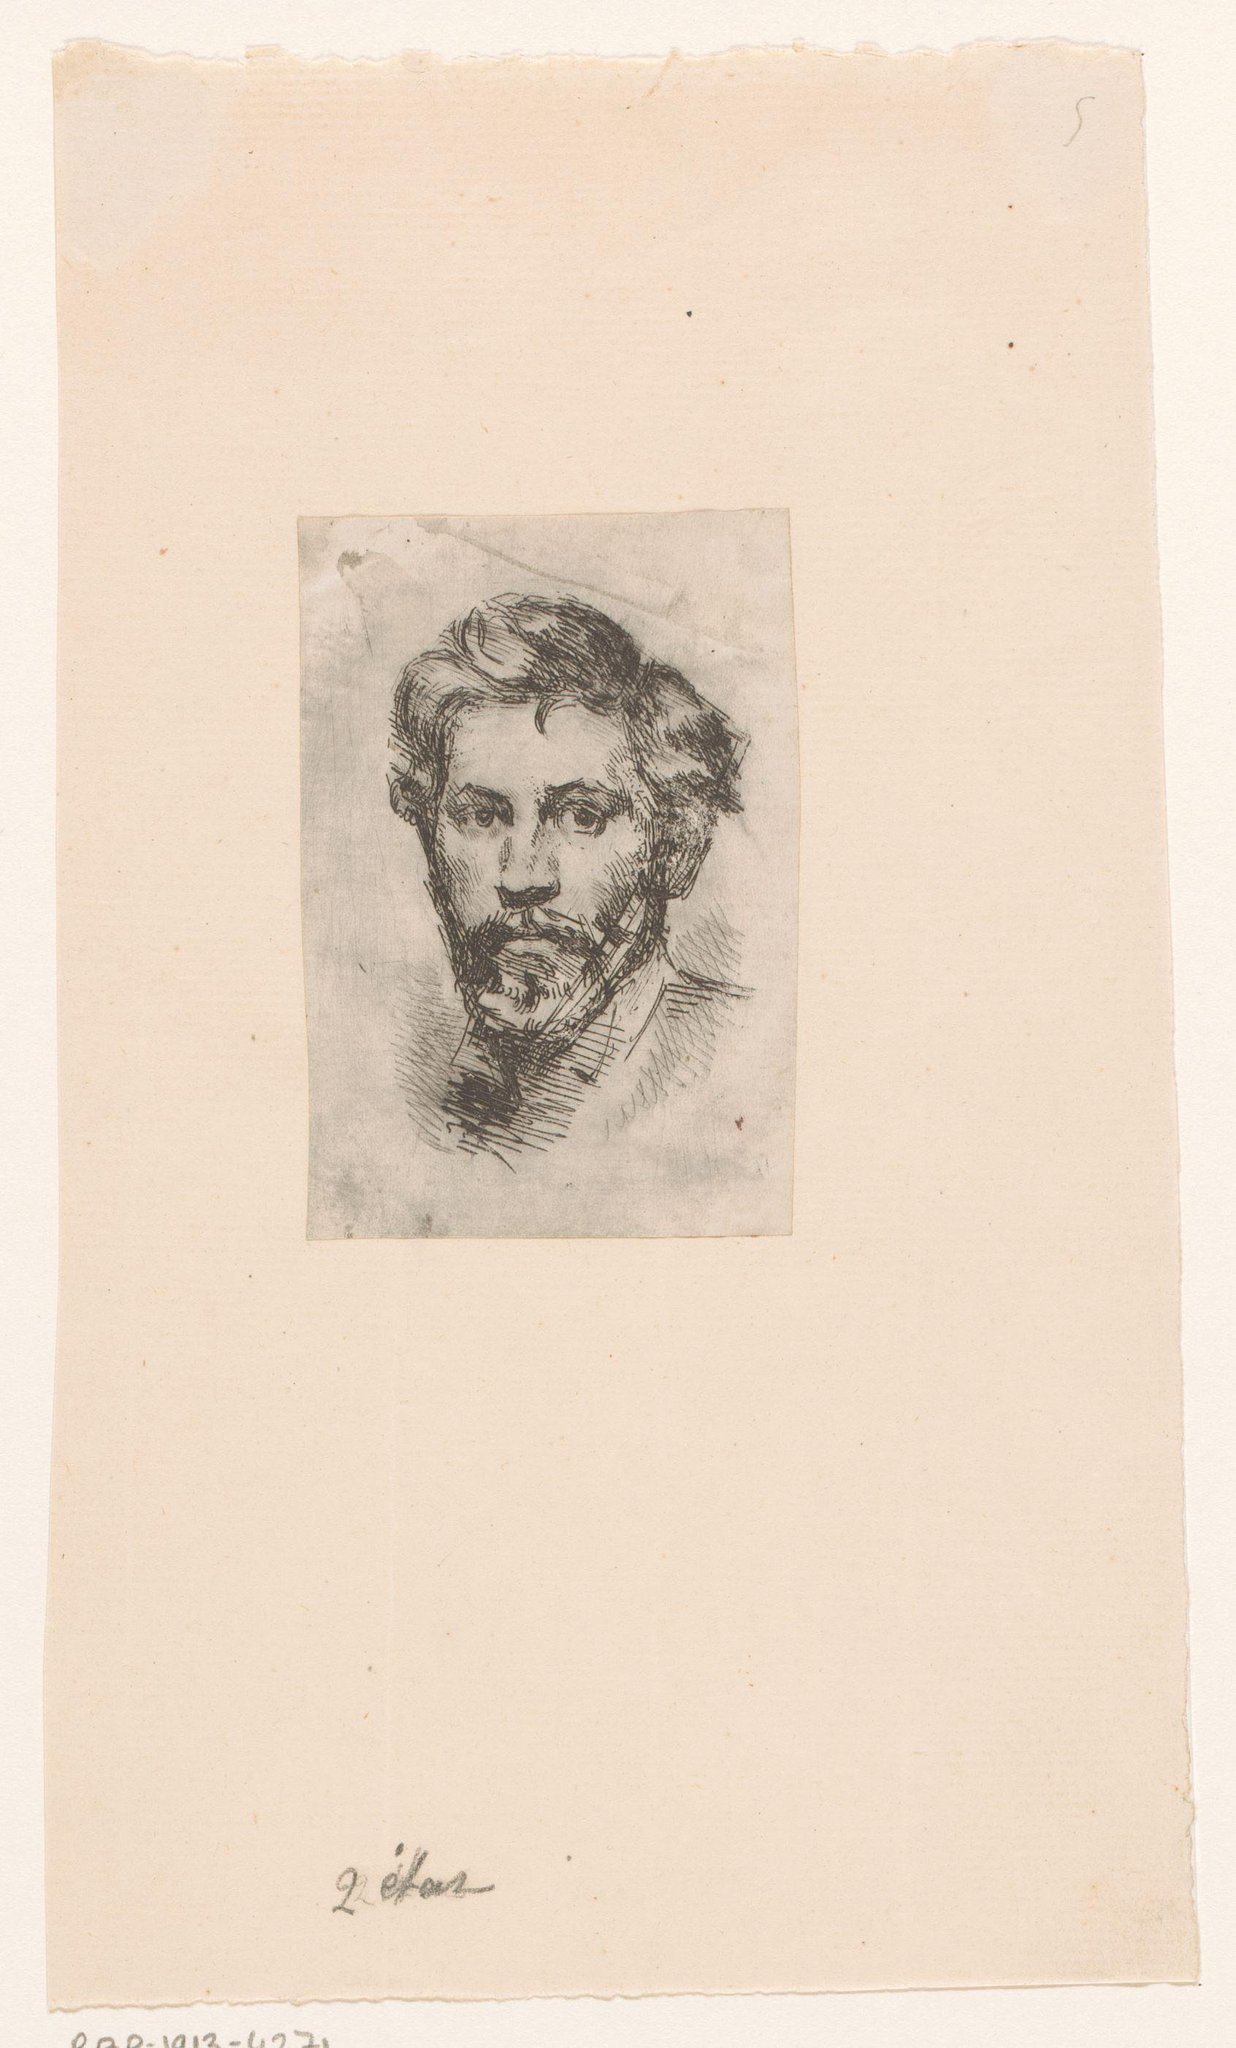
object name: print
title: Portret van een onbekende man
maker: adrien de witte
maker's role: print maker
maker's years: 1850-1935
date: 1860-1913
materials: paper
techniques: etching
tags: adult man, historical persons, beard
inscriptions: collector's mark: Lugt 2228